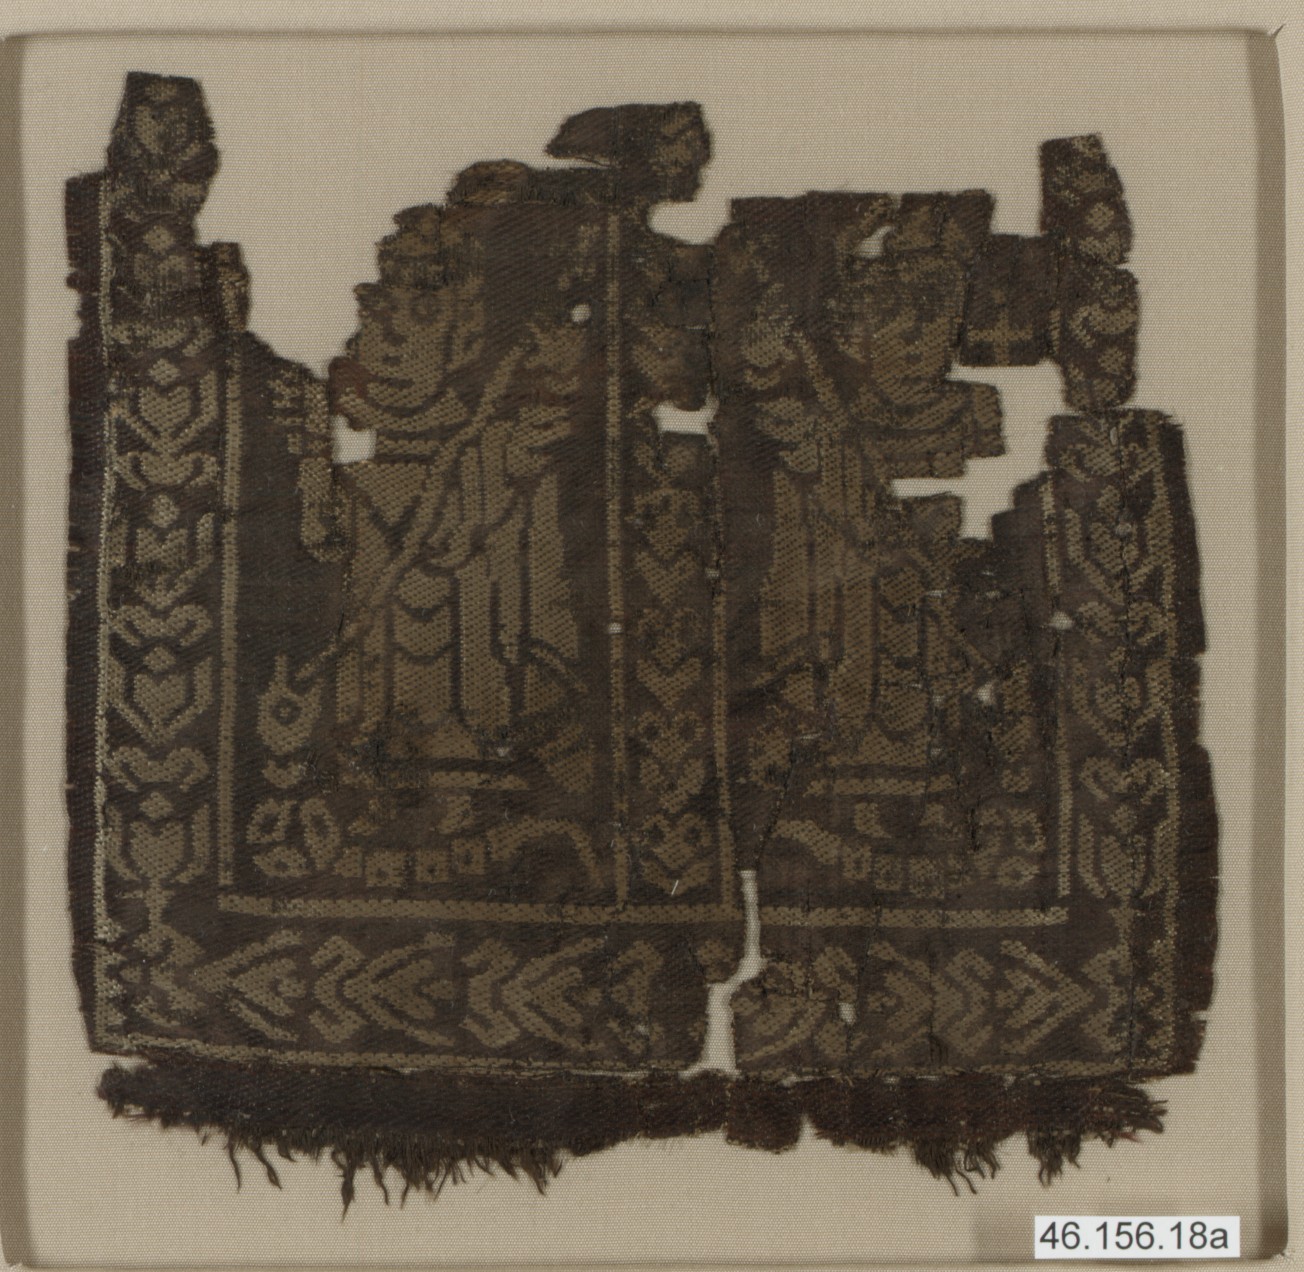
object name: textile fragment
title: Square with Holy Warriors Spearing a Serpent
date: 601-800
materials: silk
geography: egypt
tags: soldiers,serpents